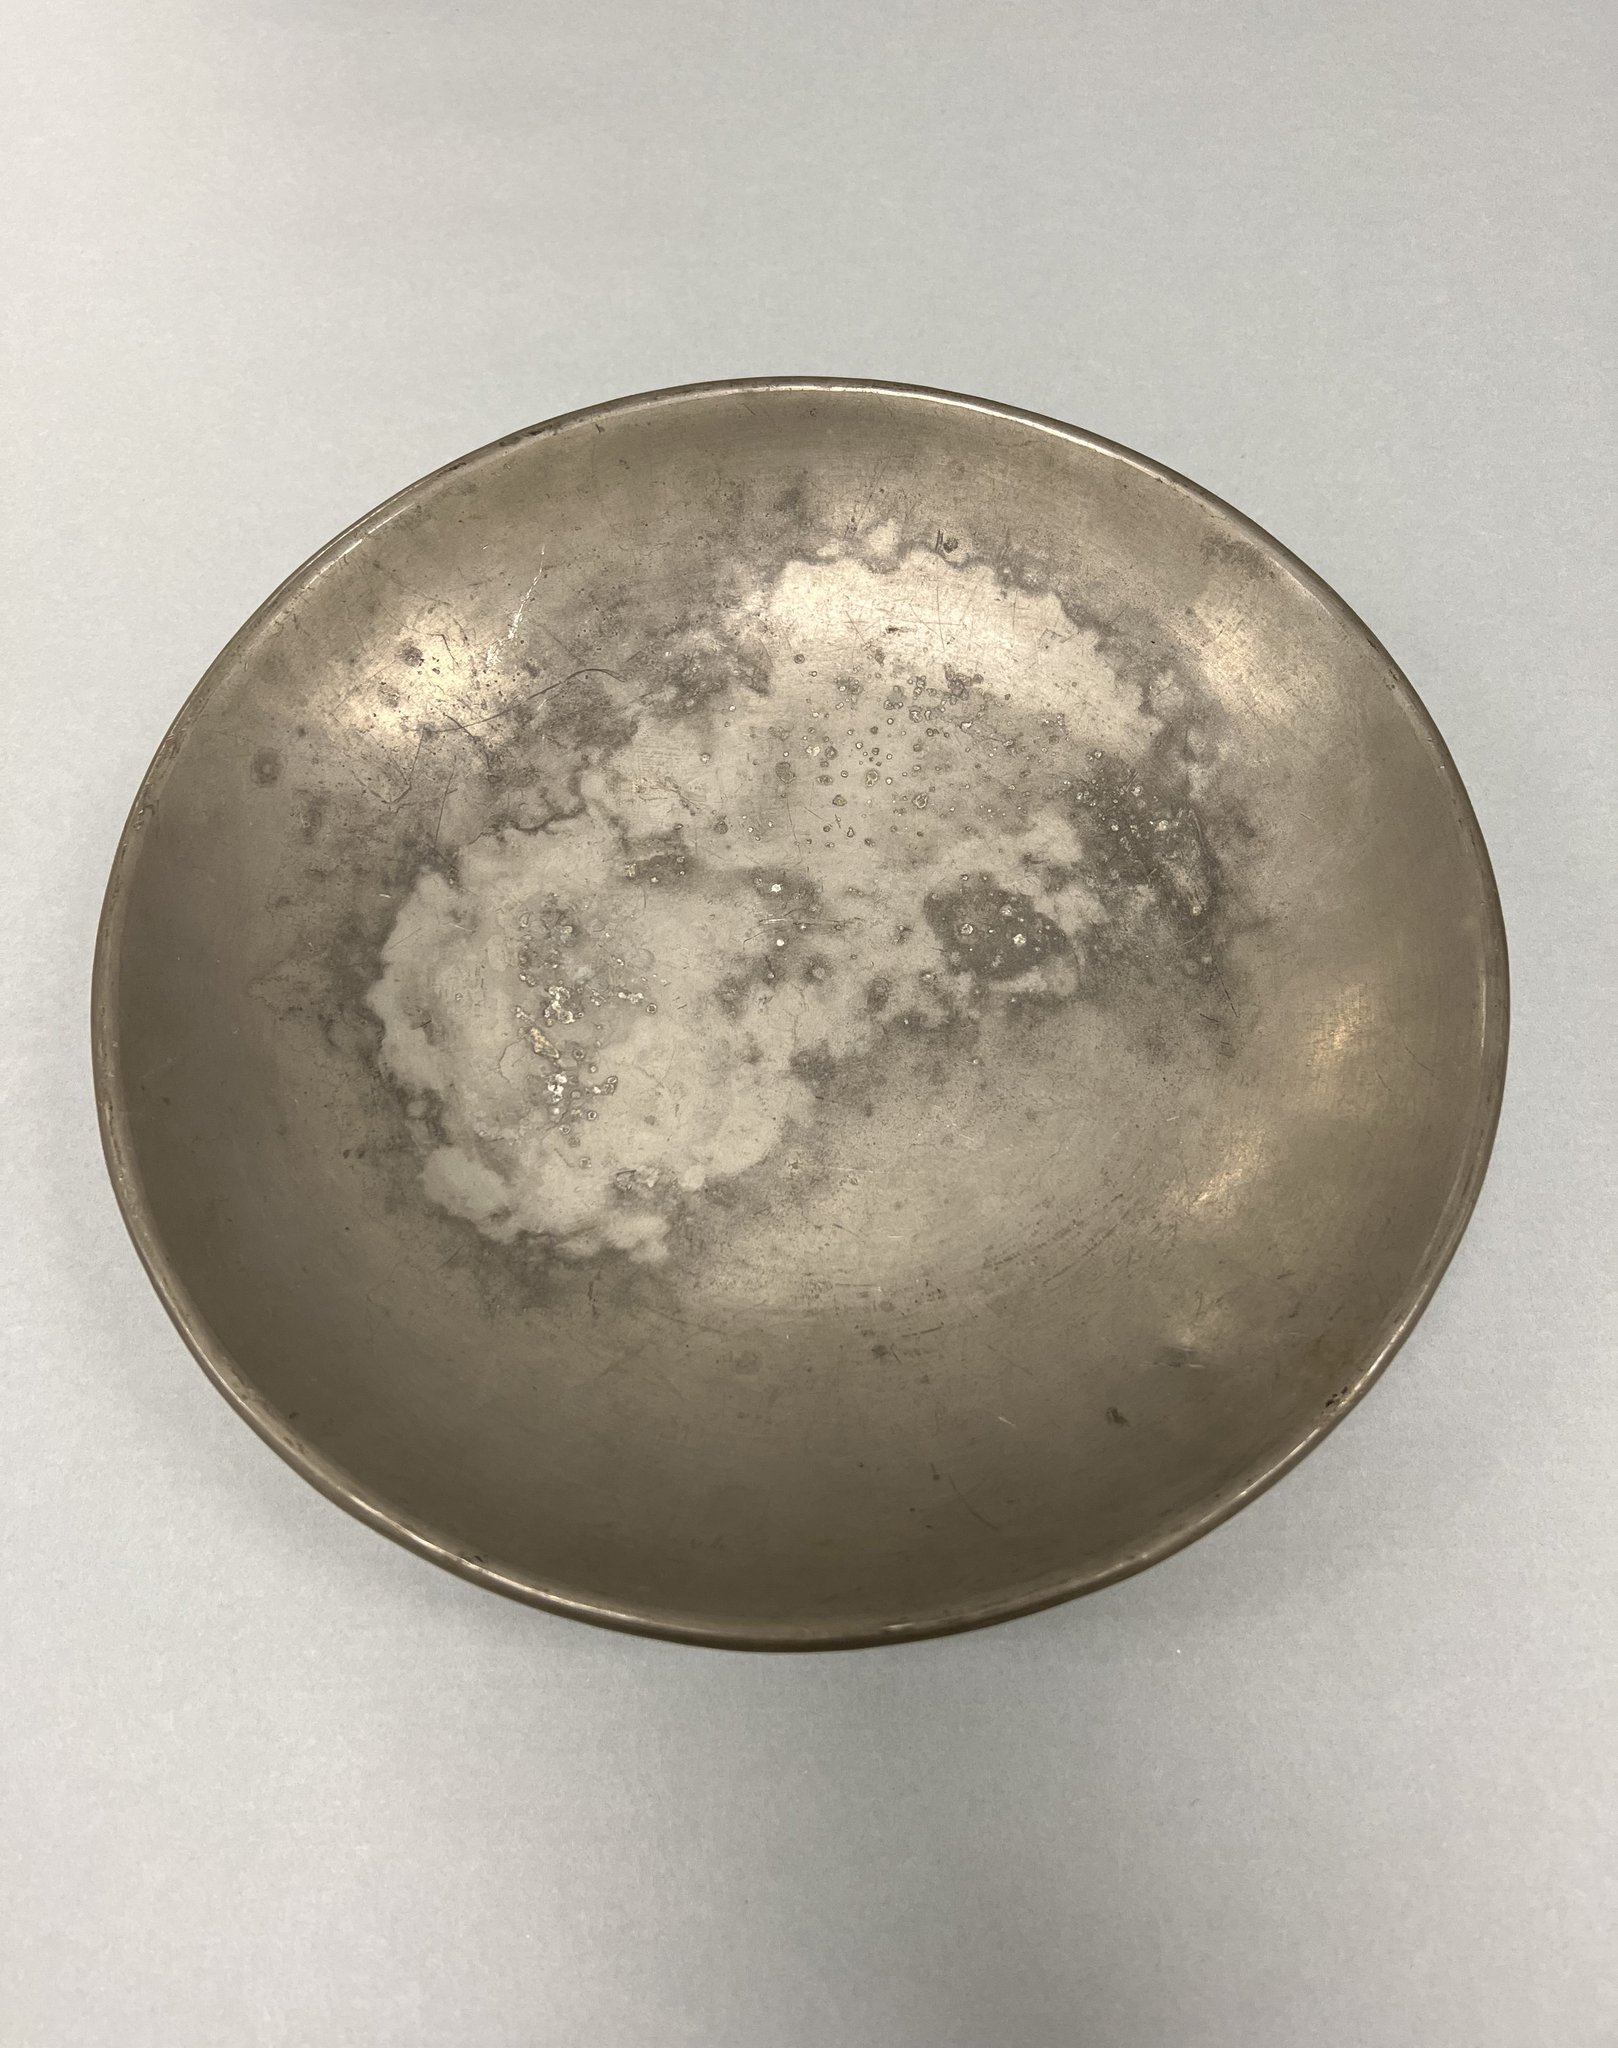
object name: plate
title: Round Plate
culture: chinese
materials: plant material, pewter